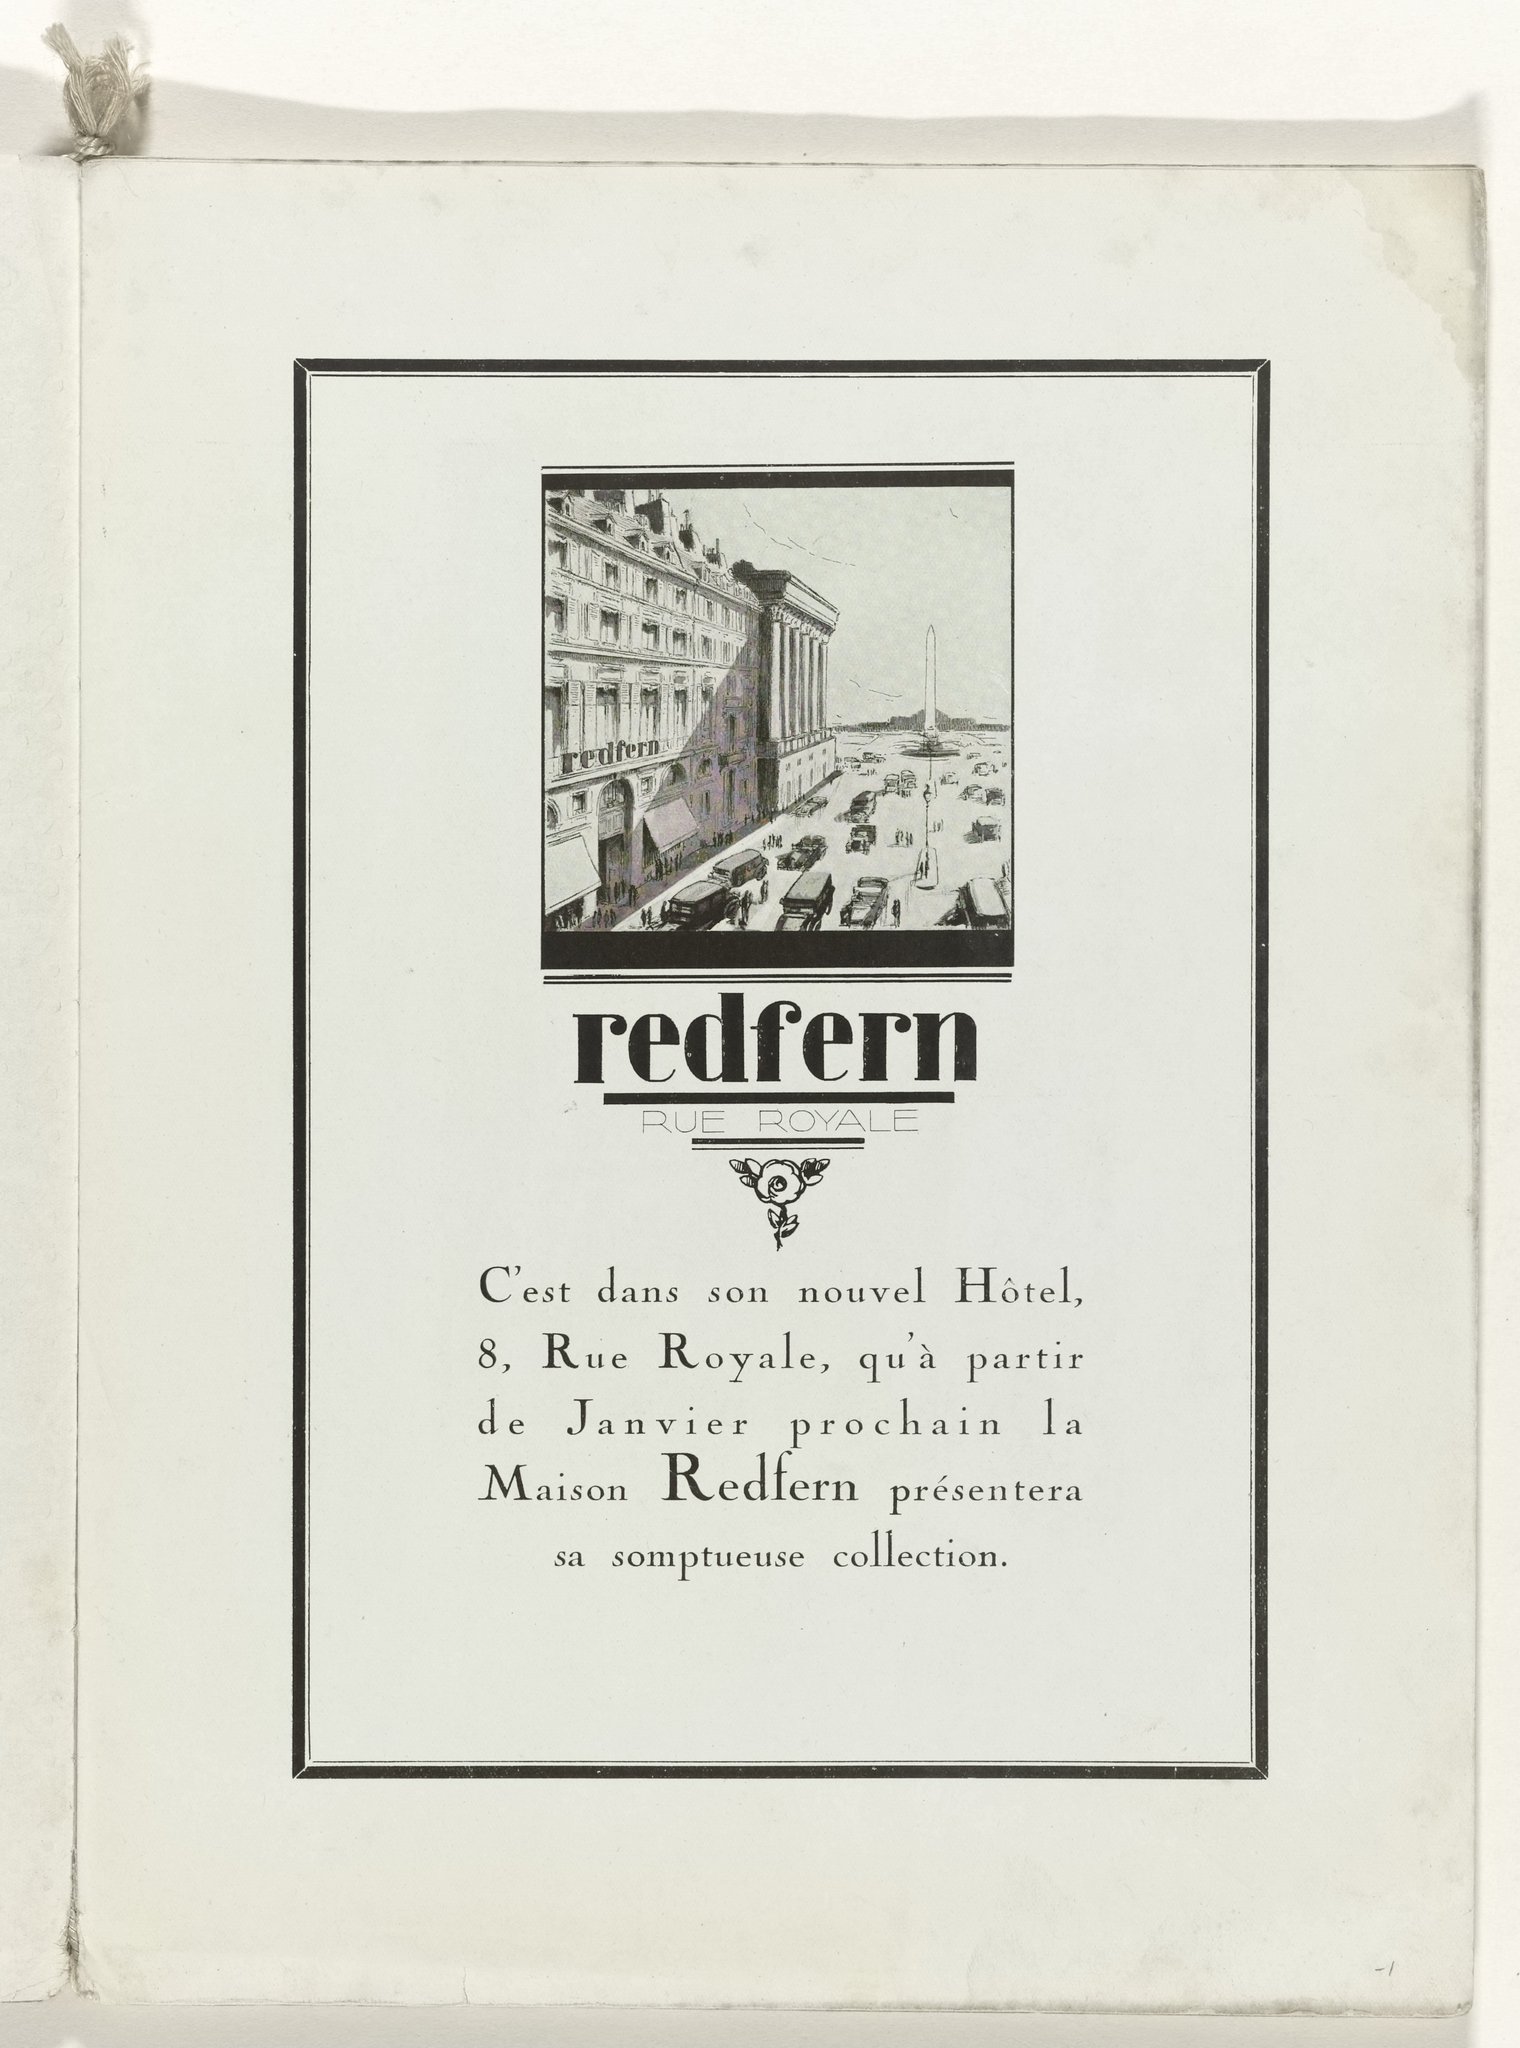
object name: fashion print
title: Art - Goût - Beauté, Feuillets de l' élégance féminine, Noël 1928, No. 100, 9e Année, p. 1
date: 1928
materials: paper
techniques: photography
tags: traffic on land, fashion plates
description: Advertentie (of aankondiging) voor een presentatie van de nieuwe collectie van Redfern. Pagina uit het modetijdschrift Art-Goût-Beauté (1920-1933).